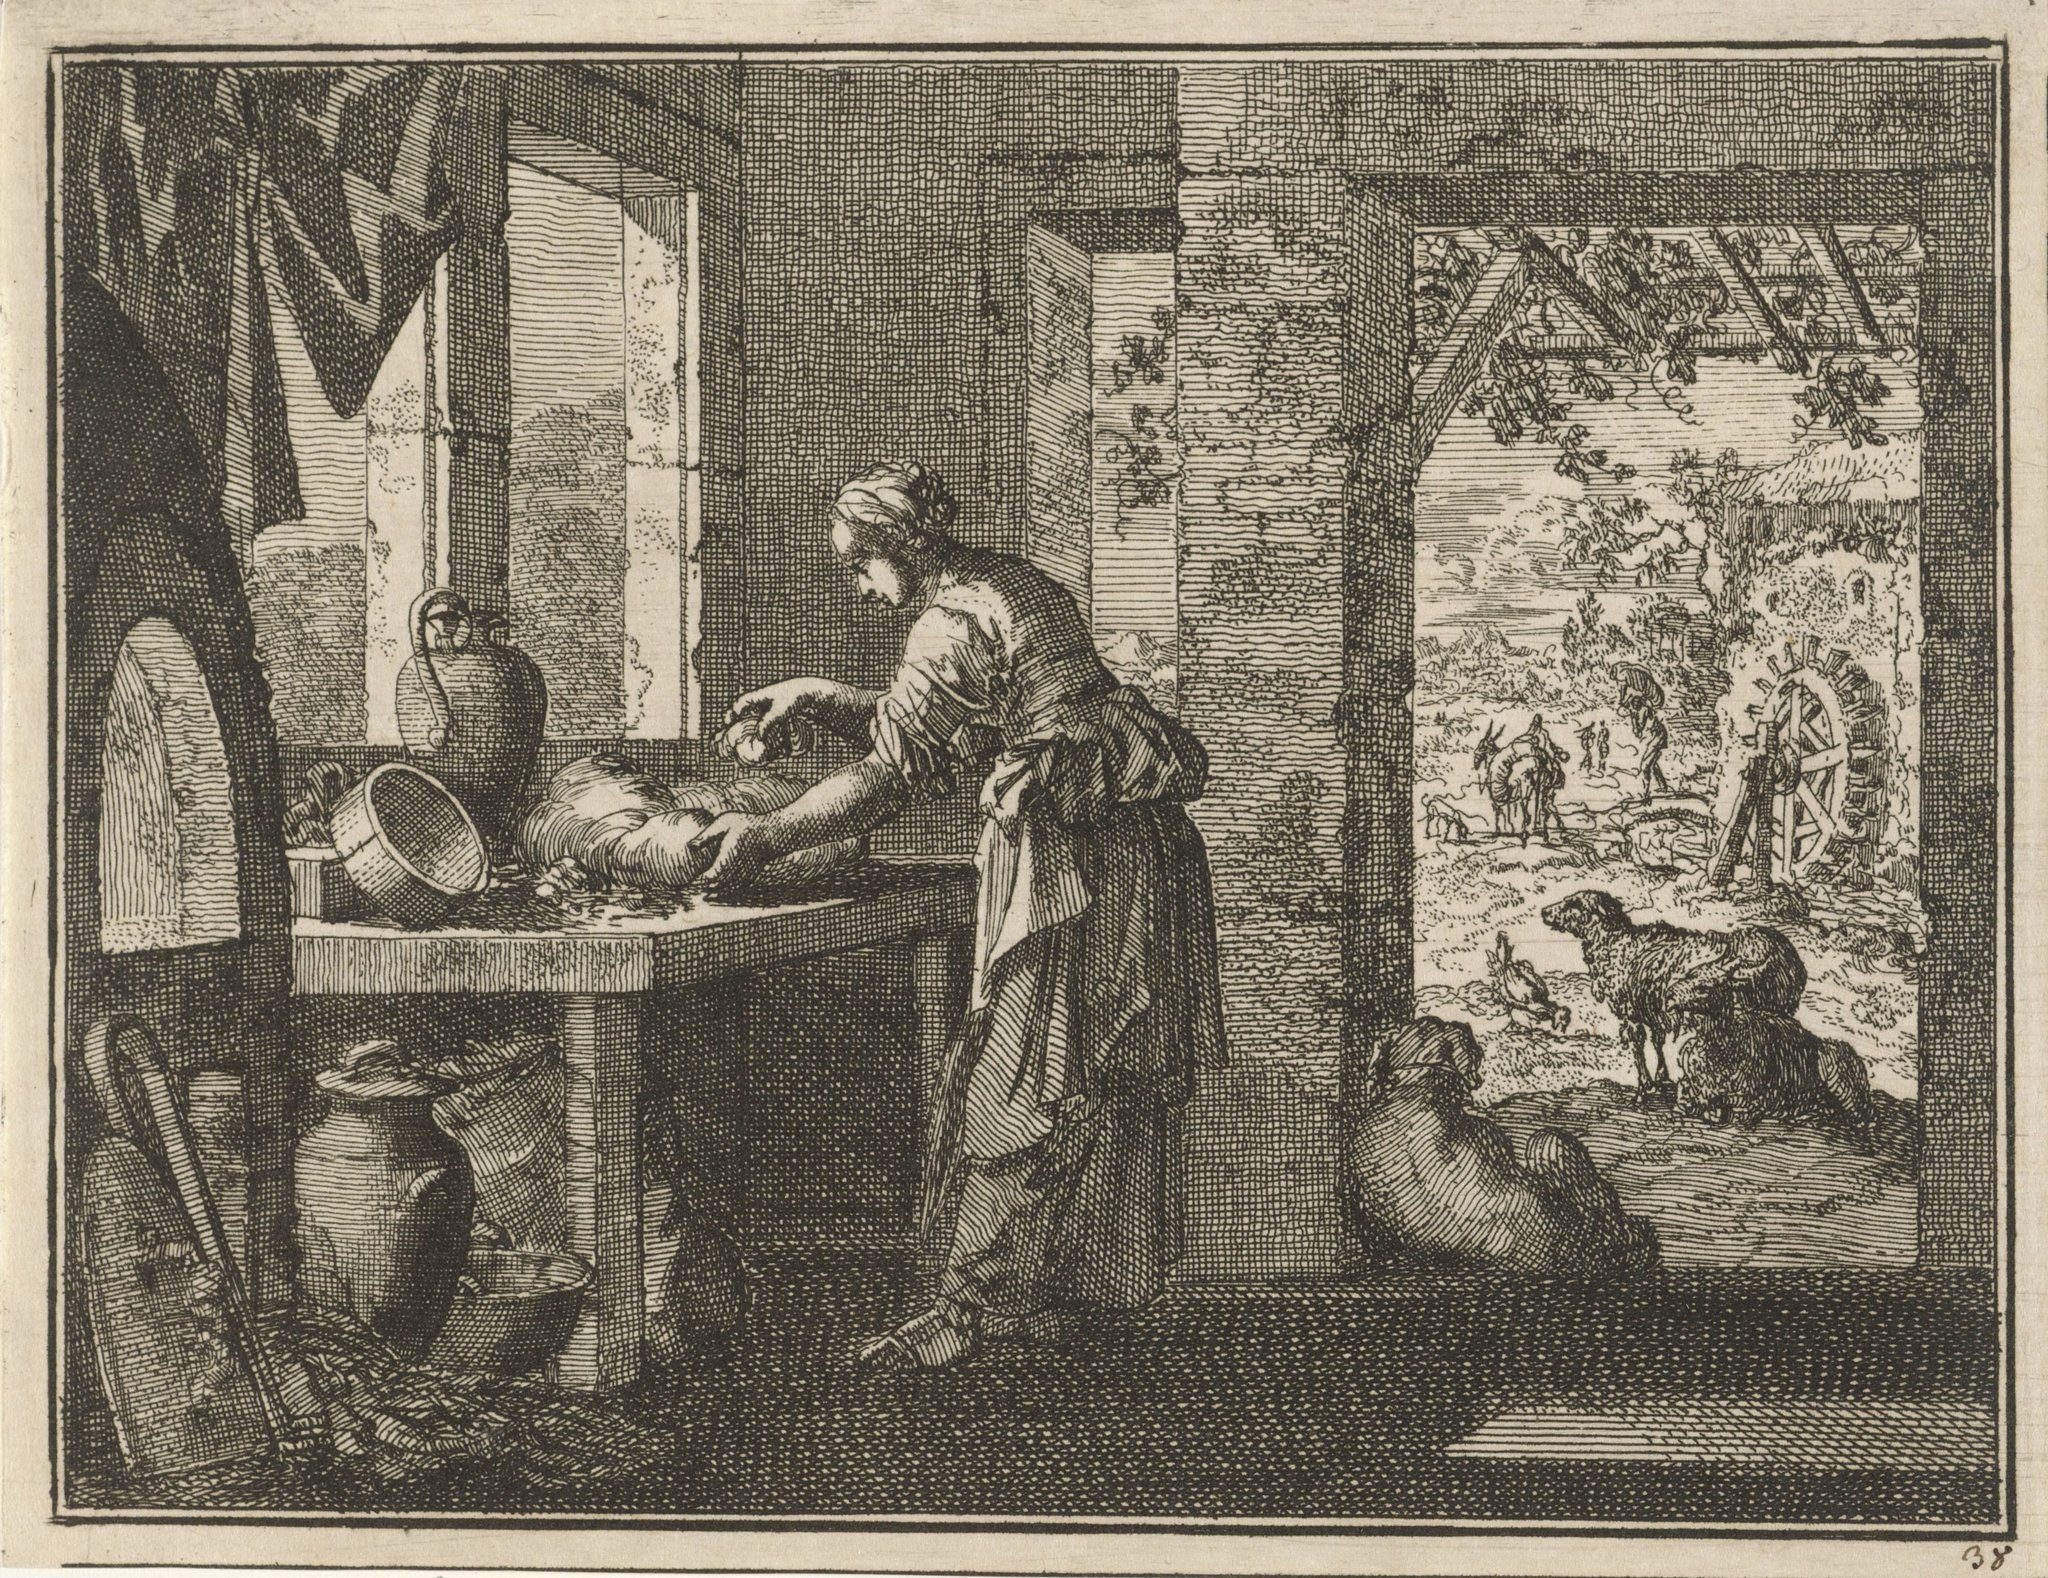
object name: print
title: Gelijkenis van de vrouw en het zuurdesem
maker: jan luyken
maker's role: draughtsman, print maker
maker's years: 1649-1712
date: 1712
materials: paper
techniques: etching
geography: amsterdam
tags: christ as teacher (part ii): parables and proverbial sayings of christ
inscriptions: collector's mark: Lugt 2228, number: ‘38’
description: Proefdruk van illustratie uit: Luyken, Jan. De schriftuurlyke geschiedenissen en gelykenissen van het Oude en Nieuwe Verbond, 2 delen. Amsterdam: Wed. Pieter Arentsz II en Cornelis van der Sys, 1712, dl. II.